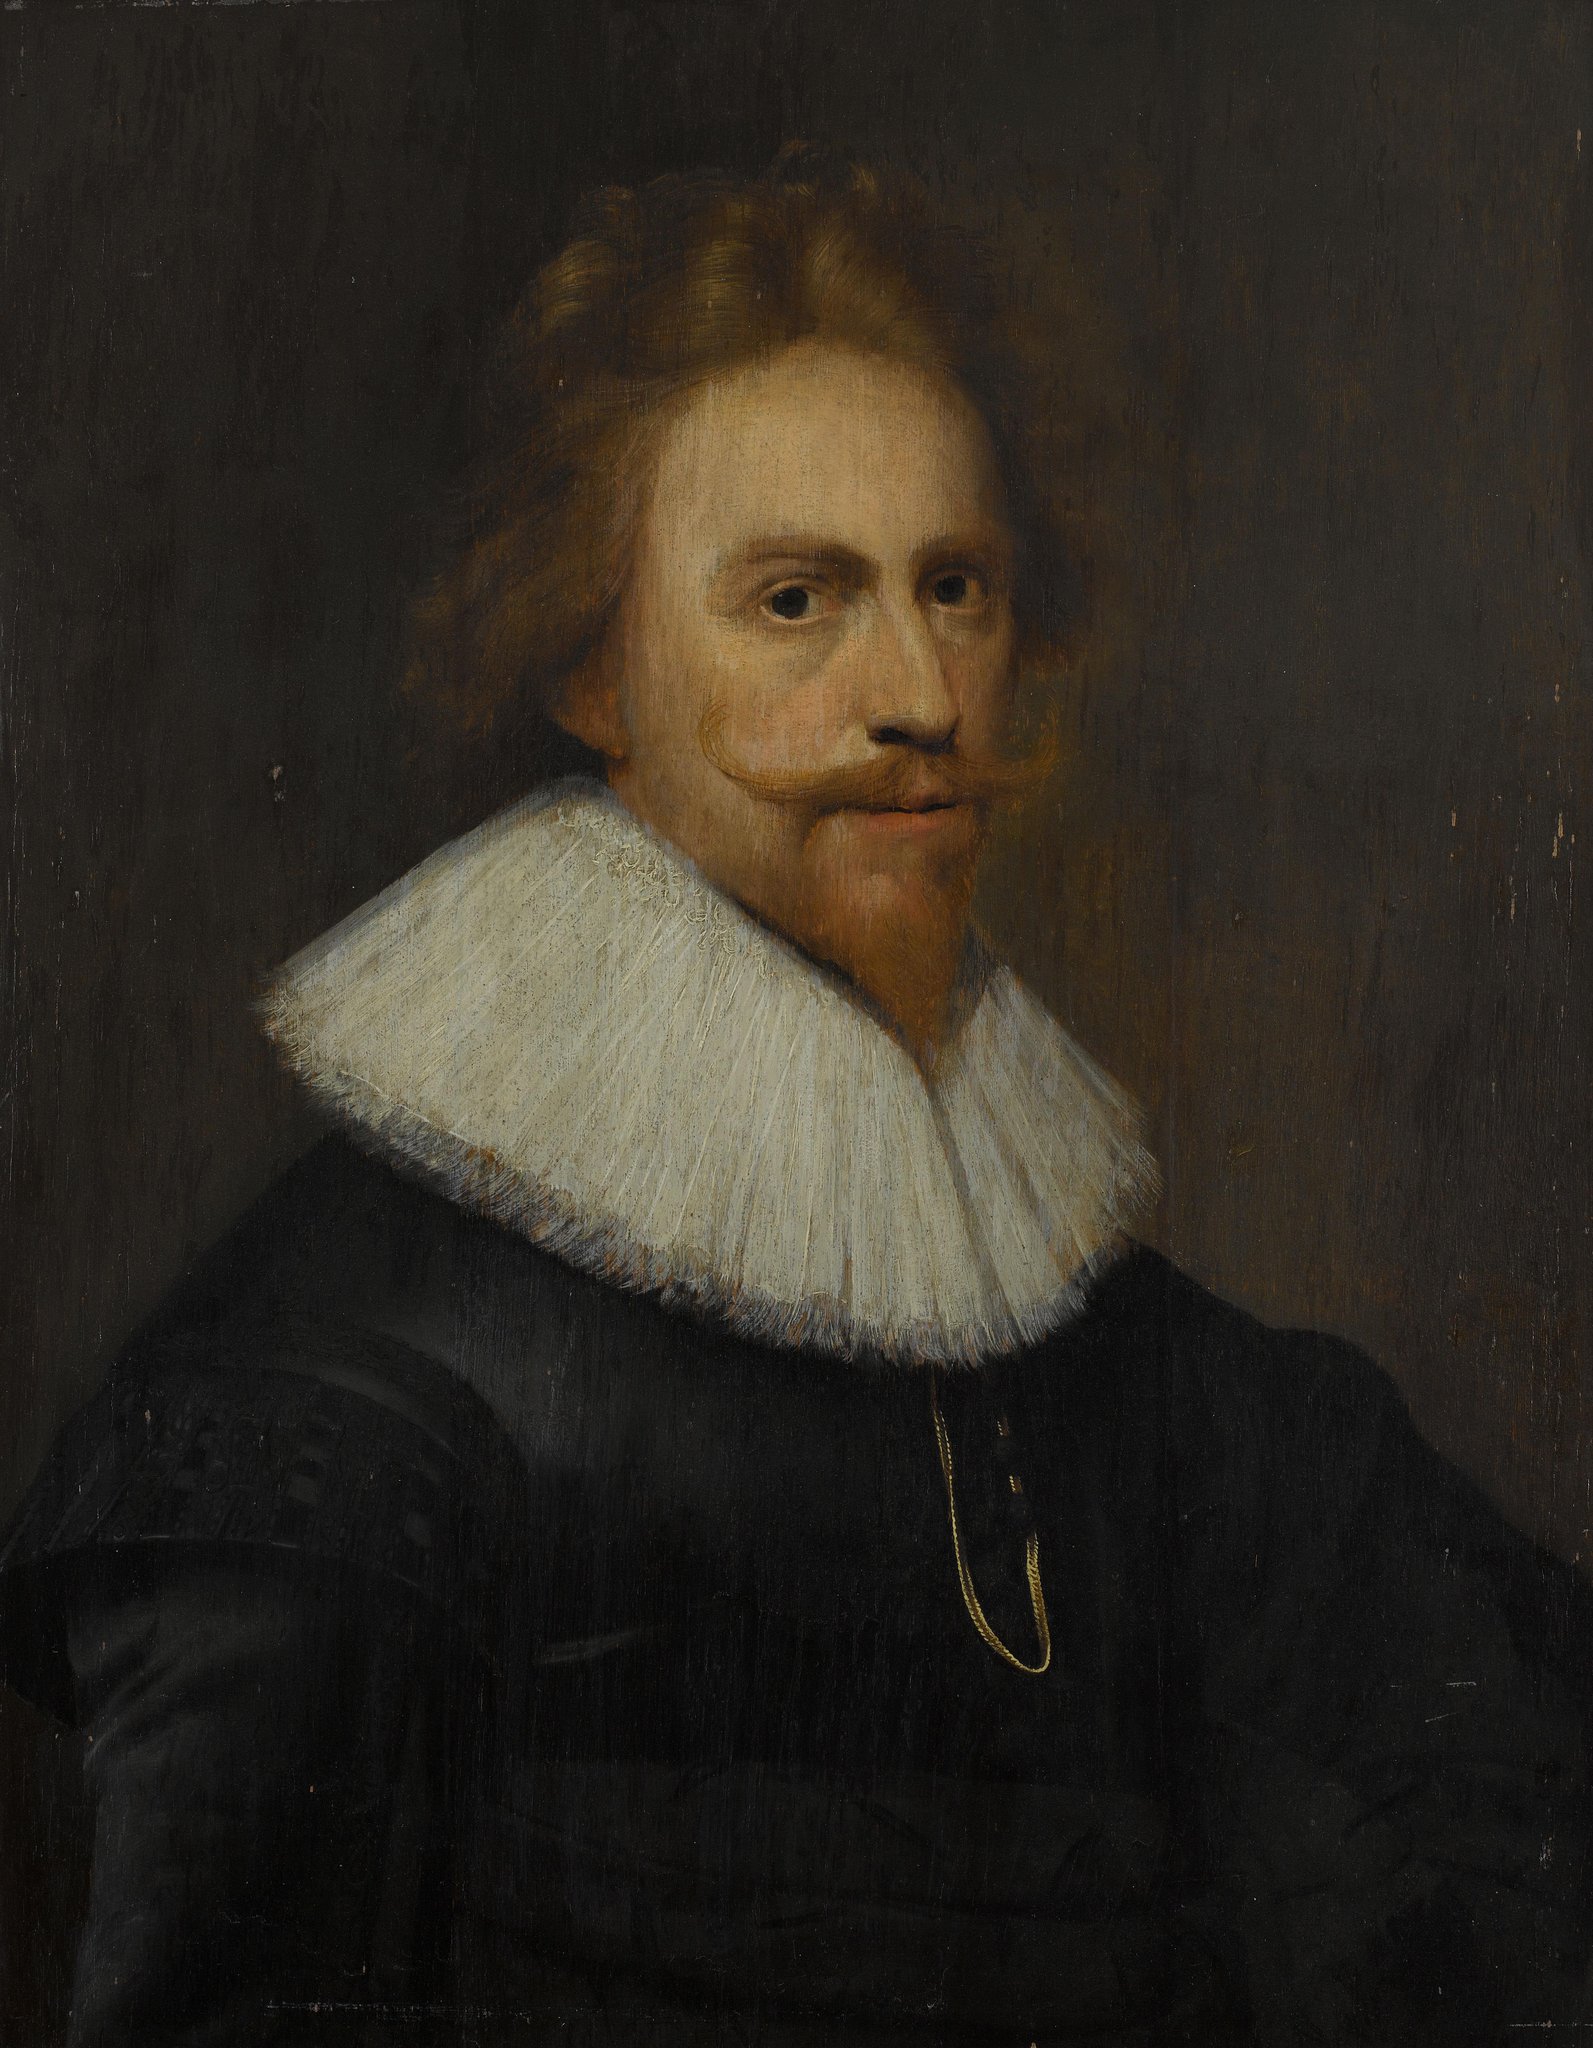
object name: painting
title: Self-Portrait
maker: wybrand de geest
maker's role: draughtsman, painter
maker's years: 1592-1665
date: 1629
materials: oil, panel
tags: painter, wybrand de geest, historical persons, portrait, self-portrait of painter, portrait, self-portrait of artist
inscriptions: date, top left, in pale green: ‘C I C [in reverse] I C [in reverse] C XXIX’, inscription, on the reverse, in white paint: ‘WIBRANT DE GEEST / GEBOREN INT’ IAER 1592 / DEN 16 VAN OOST-MAENT’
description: Portret van de schilder Wybrand de Geest. Buste naar rechts, om de hals een gouden ketting. Pendant van SK-A-1781.